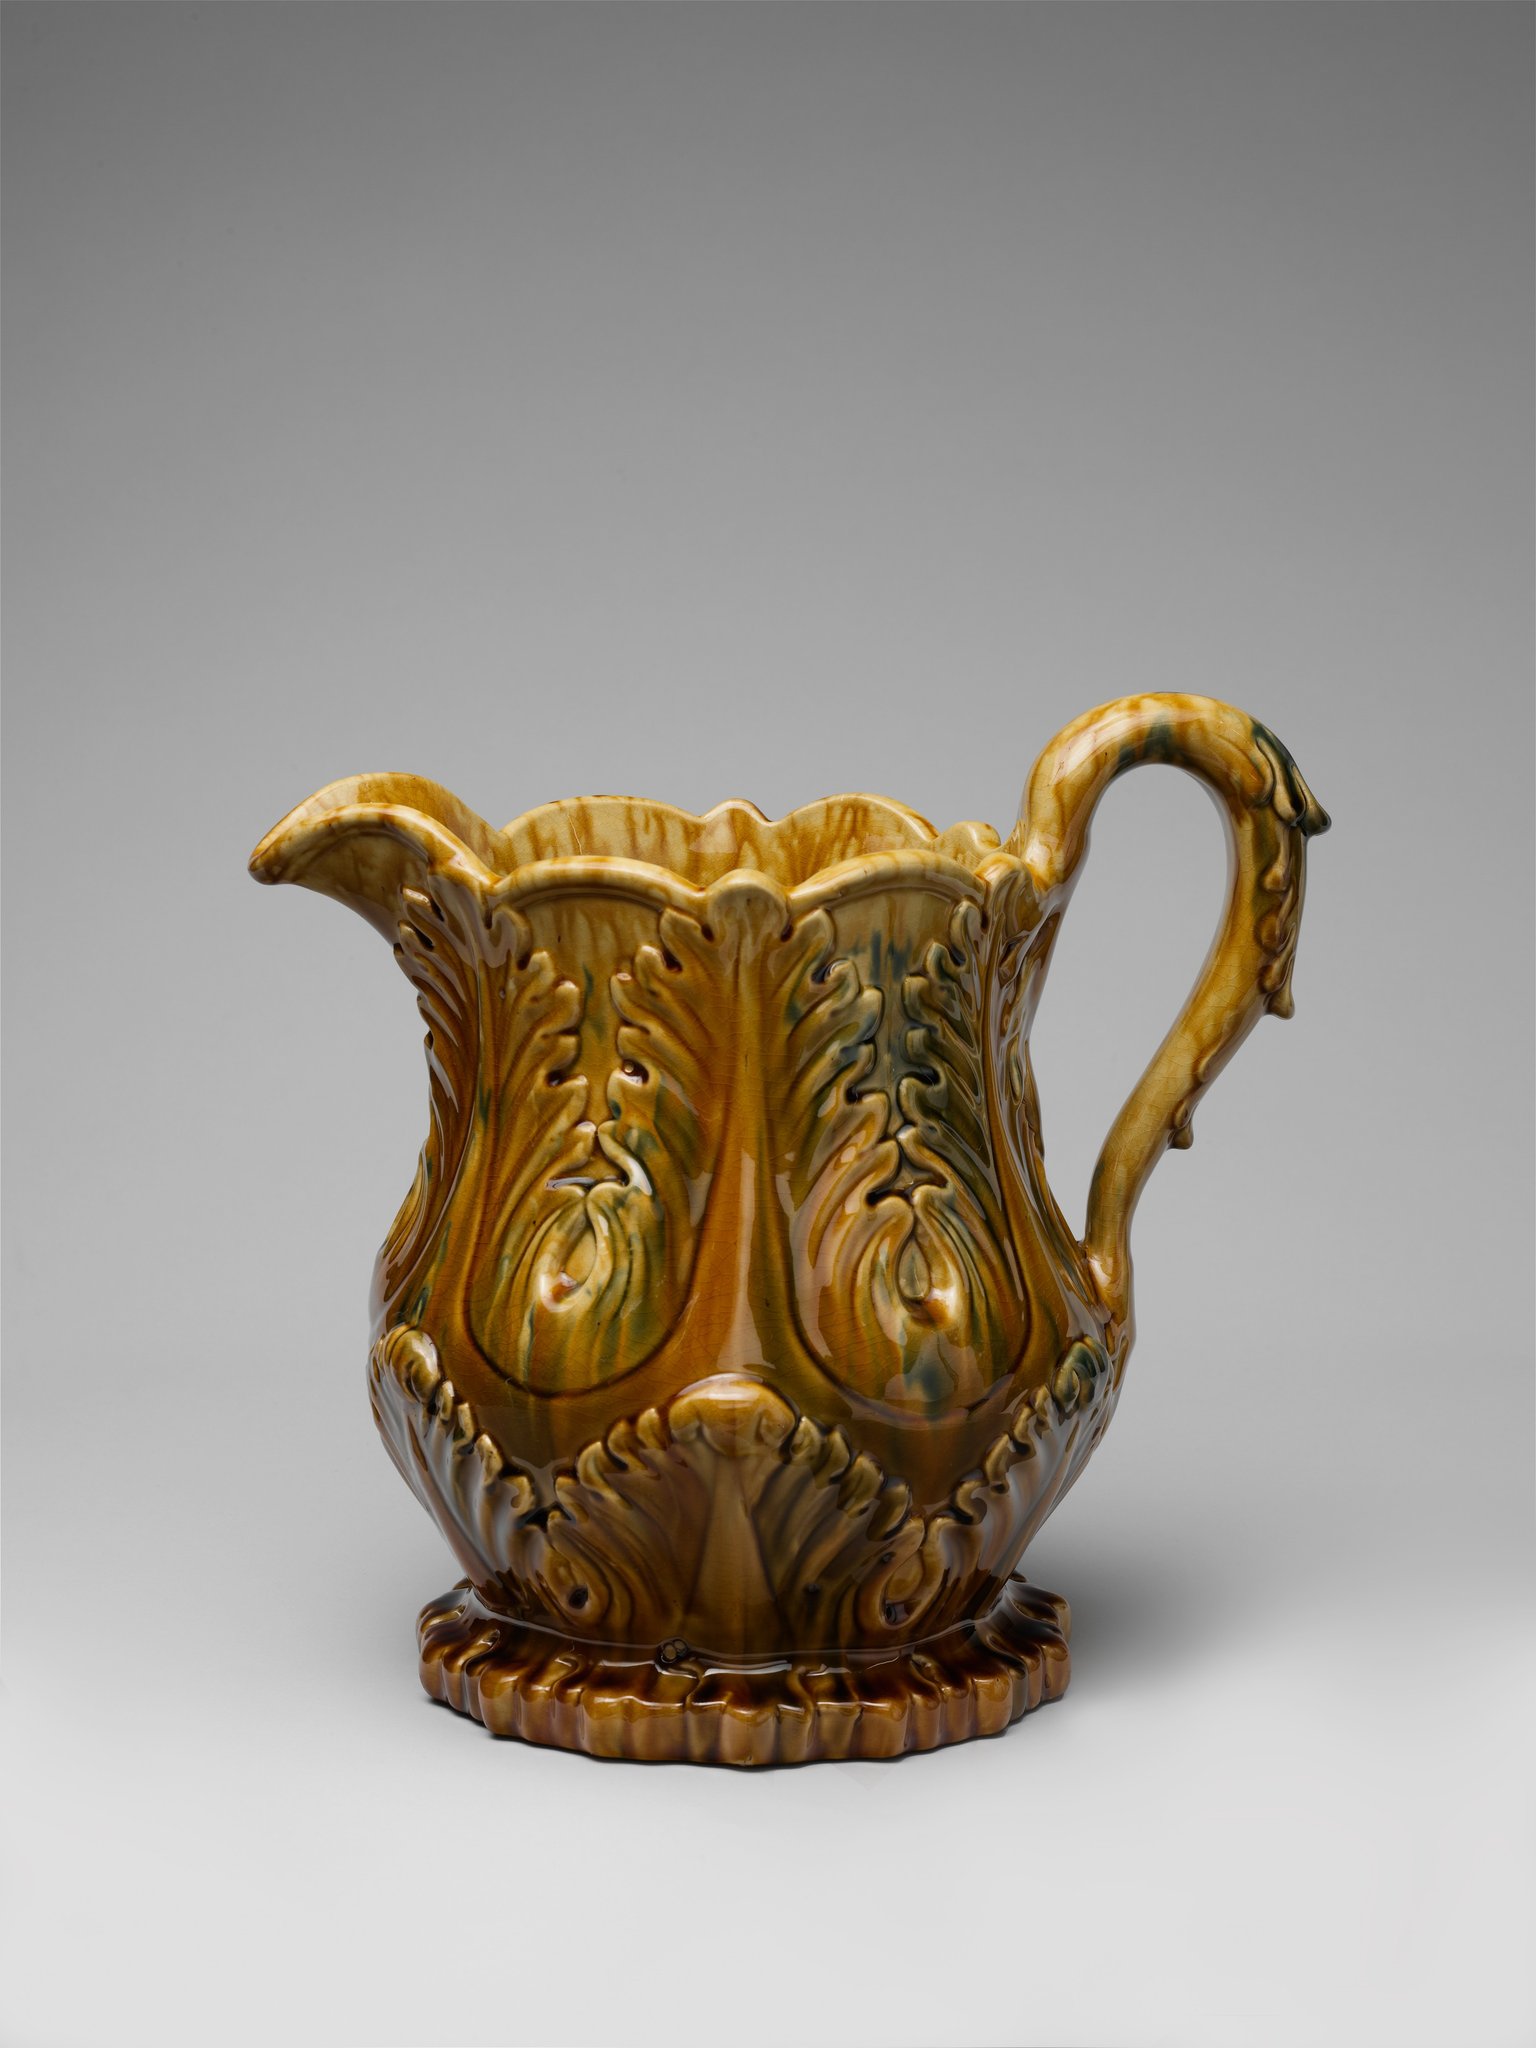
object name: pitcher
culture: american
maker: woodward and blakely company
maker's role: manufacturer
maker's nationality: american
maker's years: 1848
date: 1848-1857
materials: earthenware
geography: united states